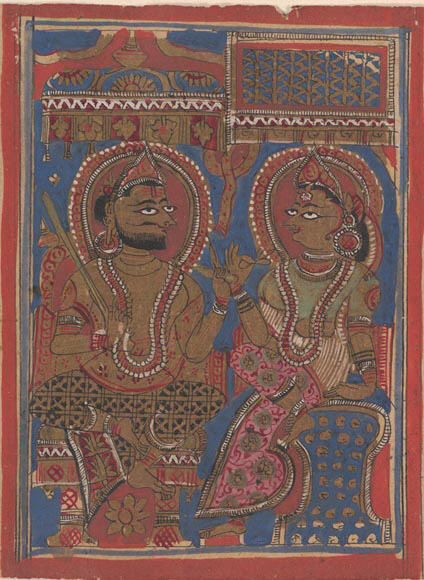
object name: folio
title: King Siddhartha Tells Queen Trisala the Meaning of the Fourteen Dreams (left) and The Interpretation of Dreams (right): Folio from a Kalpasutra Manuscript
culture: indian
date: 1401-1500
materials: gold, ink, paper, watercolor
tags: kings,queens